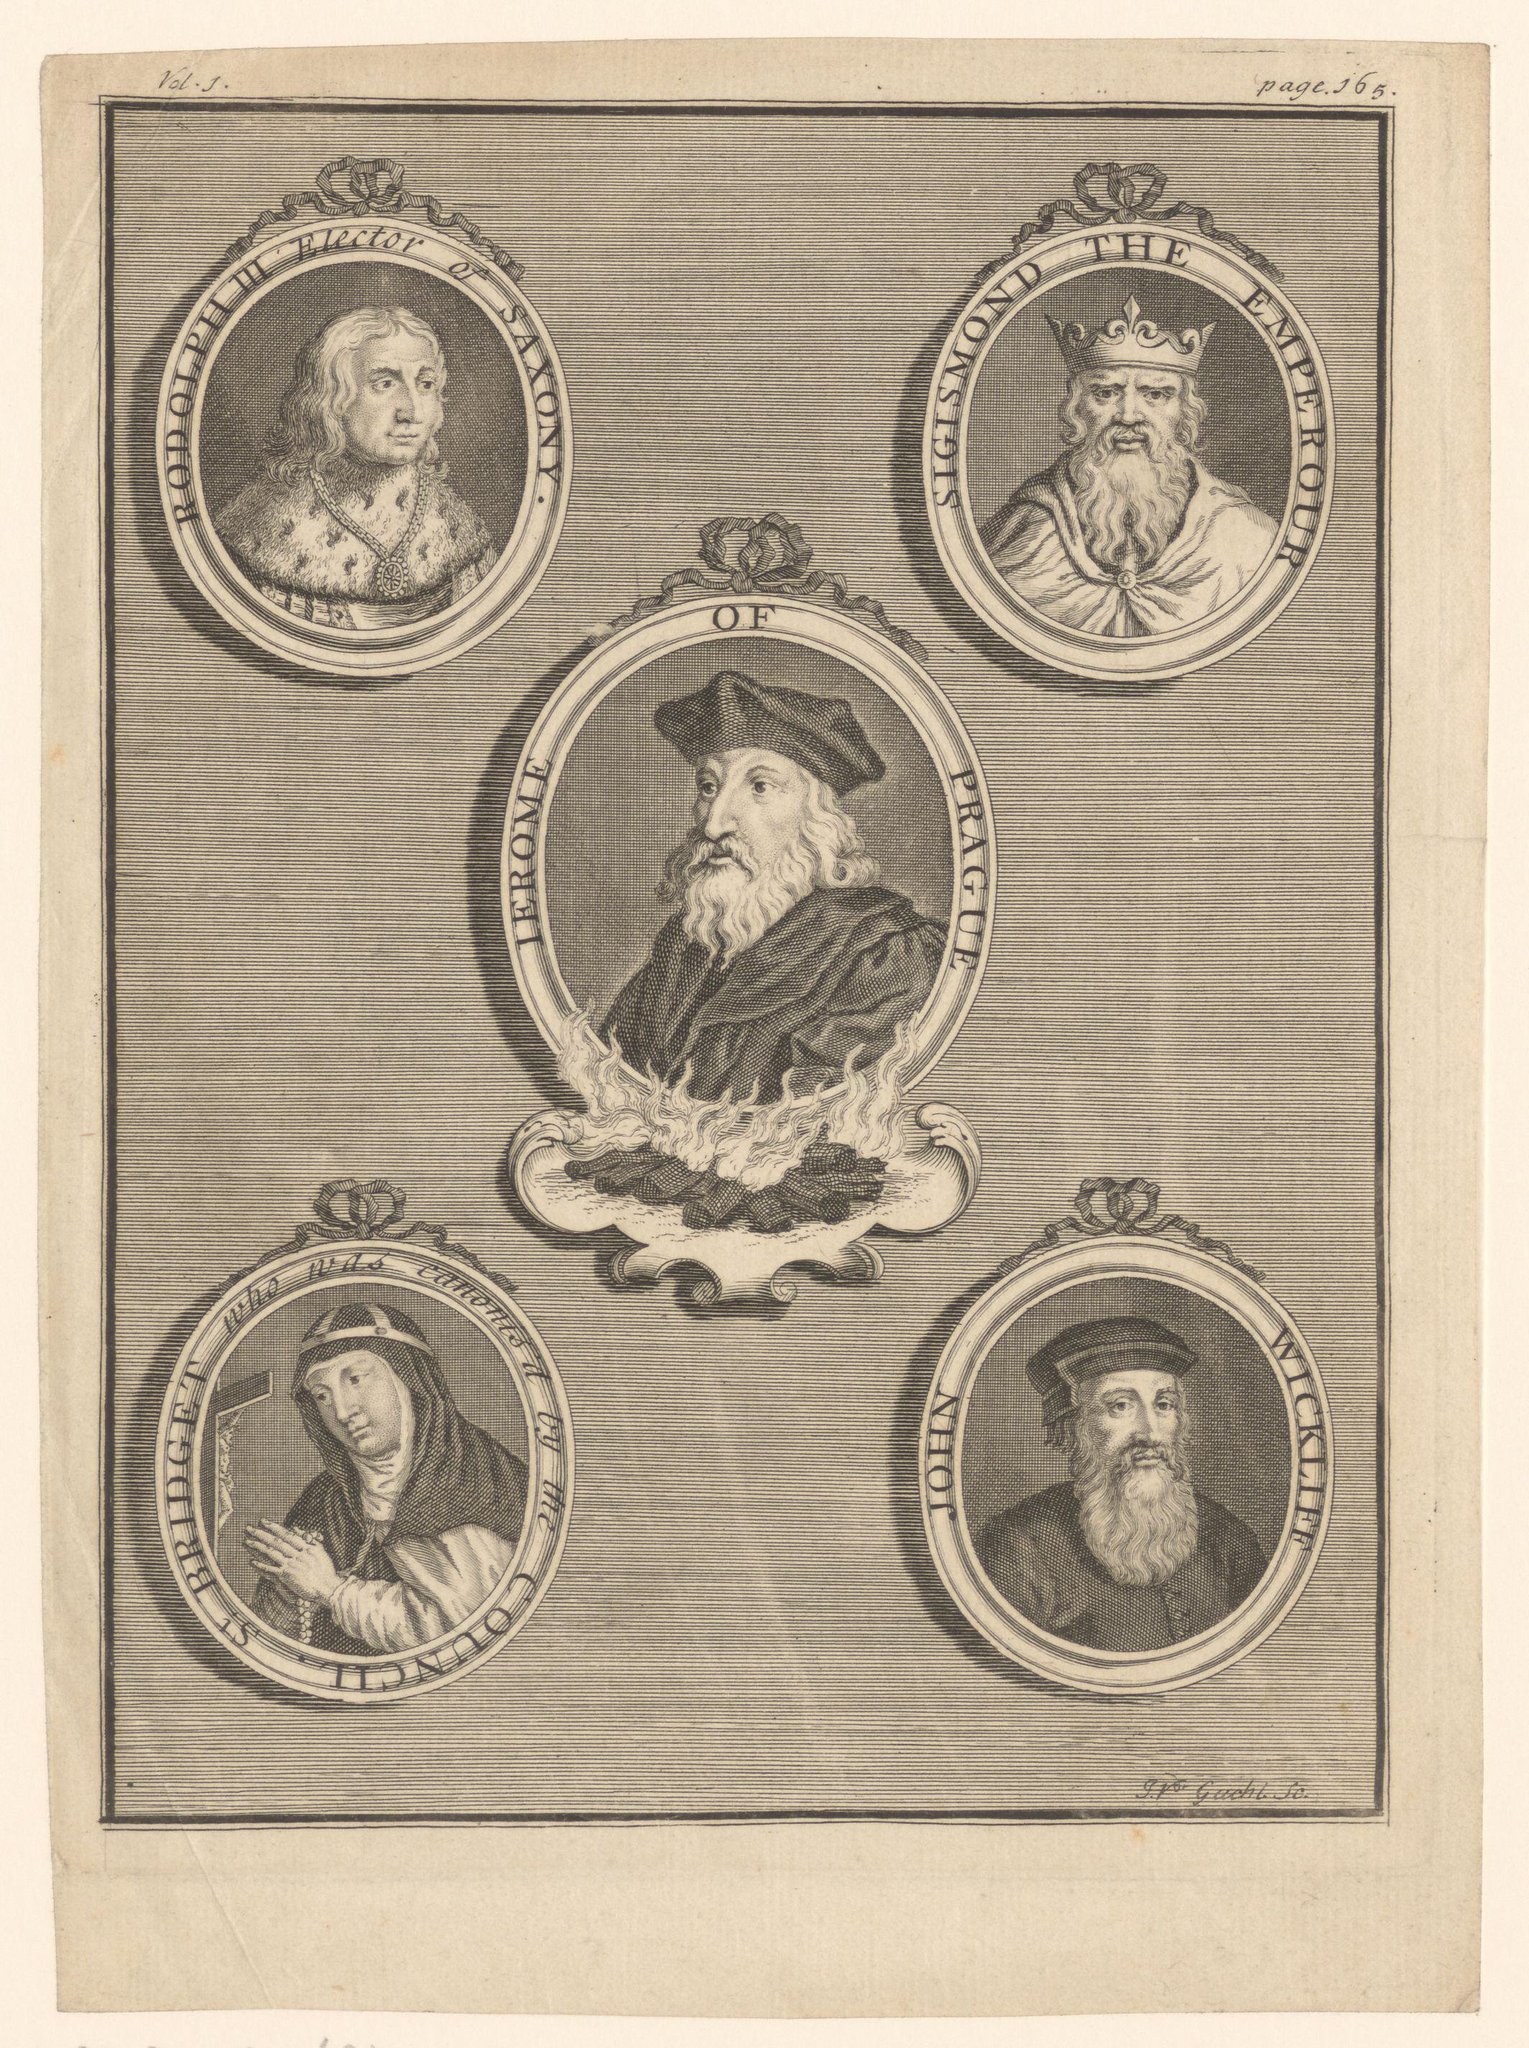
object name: print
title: Vijf portretten in medaillons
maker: john van der gucht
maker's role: print maker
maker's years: 1697-1776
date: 1709-1730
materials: paper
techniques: etching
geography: england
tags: the foundress of the order of bri(d)gettines, the widow bridget (birgitta) of sweden; possible attributes: band over veil with five red spots, book, candle, heart with cross, inkhorn, pilgrim's hat, staff, wallet, historical persons, ruler, sovereign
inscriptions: collector's mark: Lugt 2228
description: Prent komt uit een niet geïdentificeerde publicatie, zie ook RP-P-1908-883 en RP-P-1908-3857.